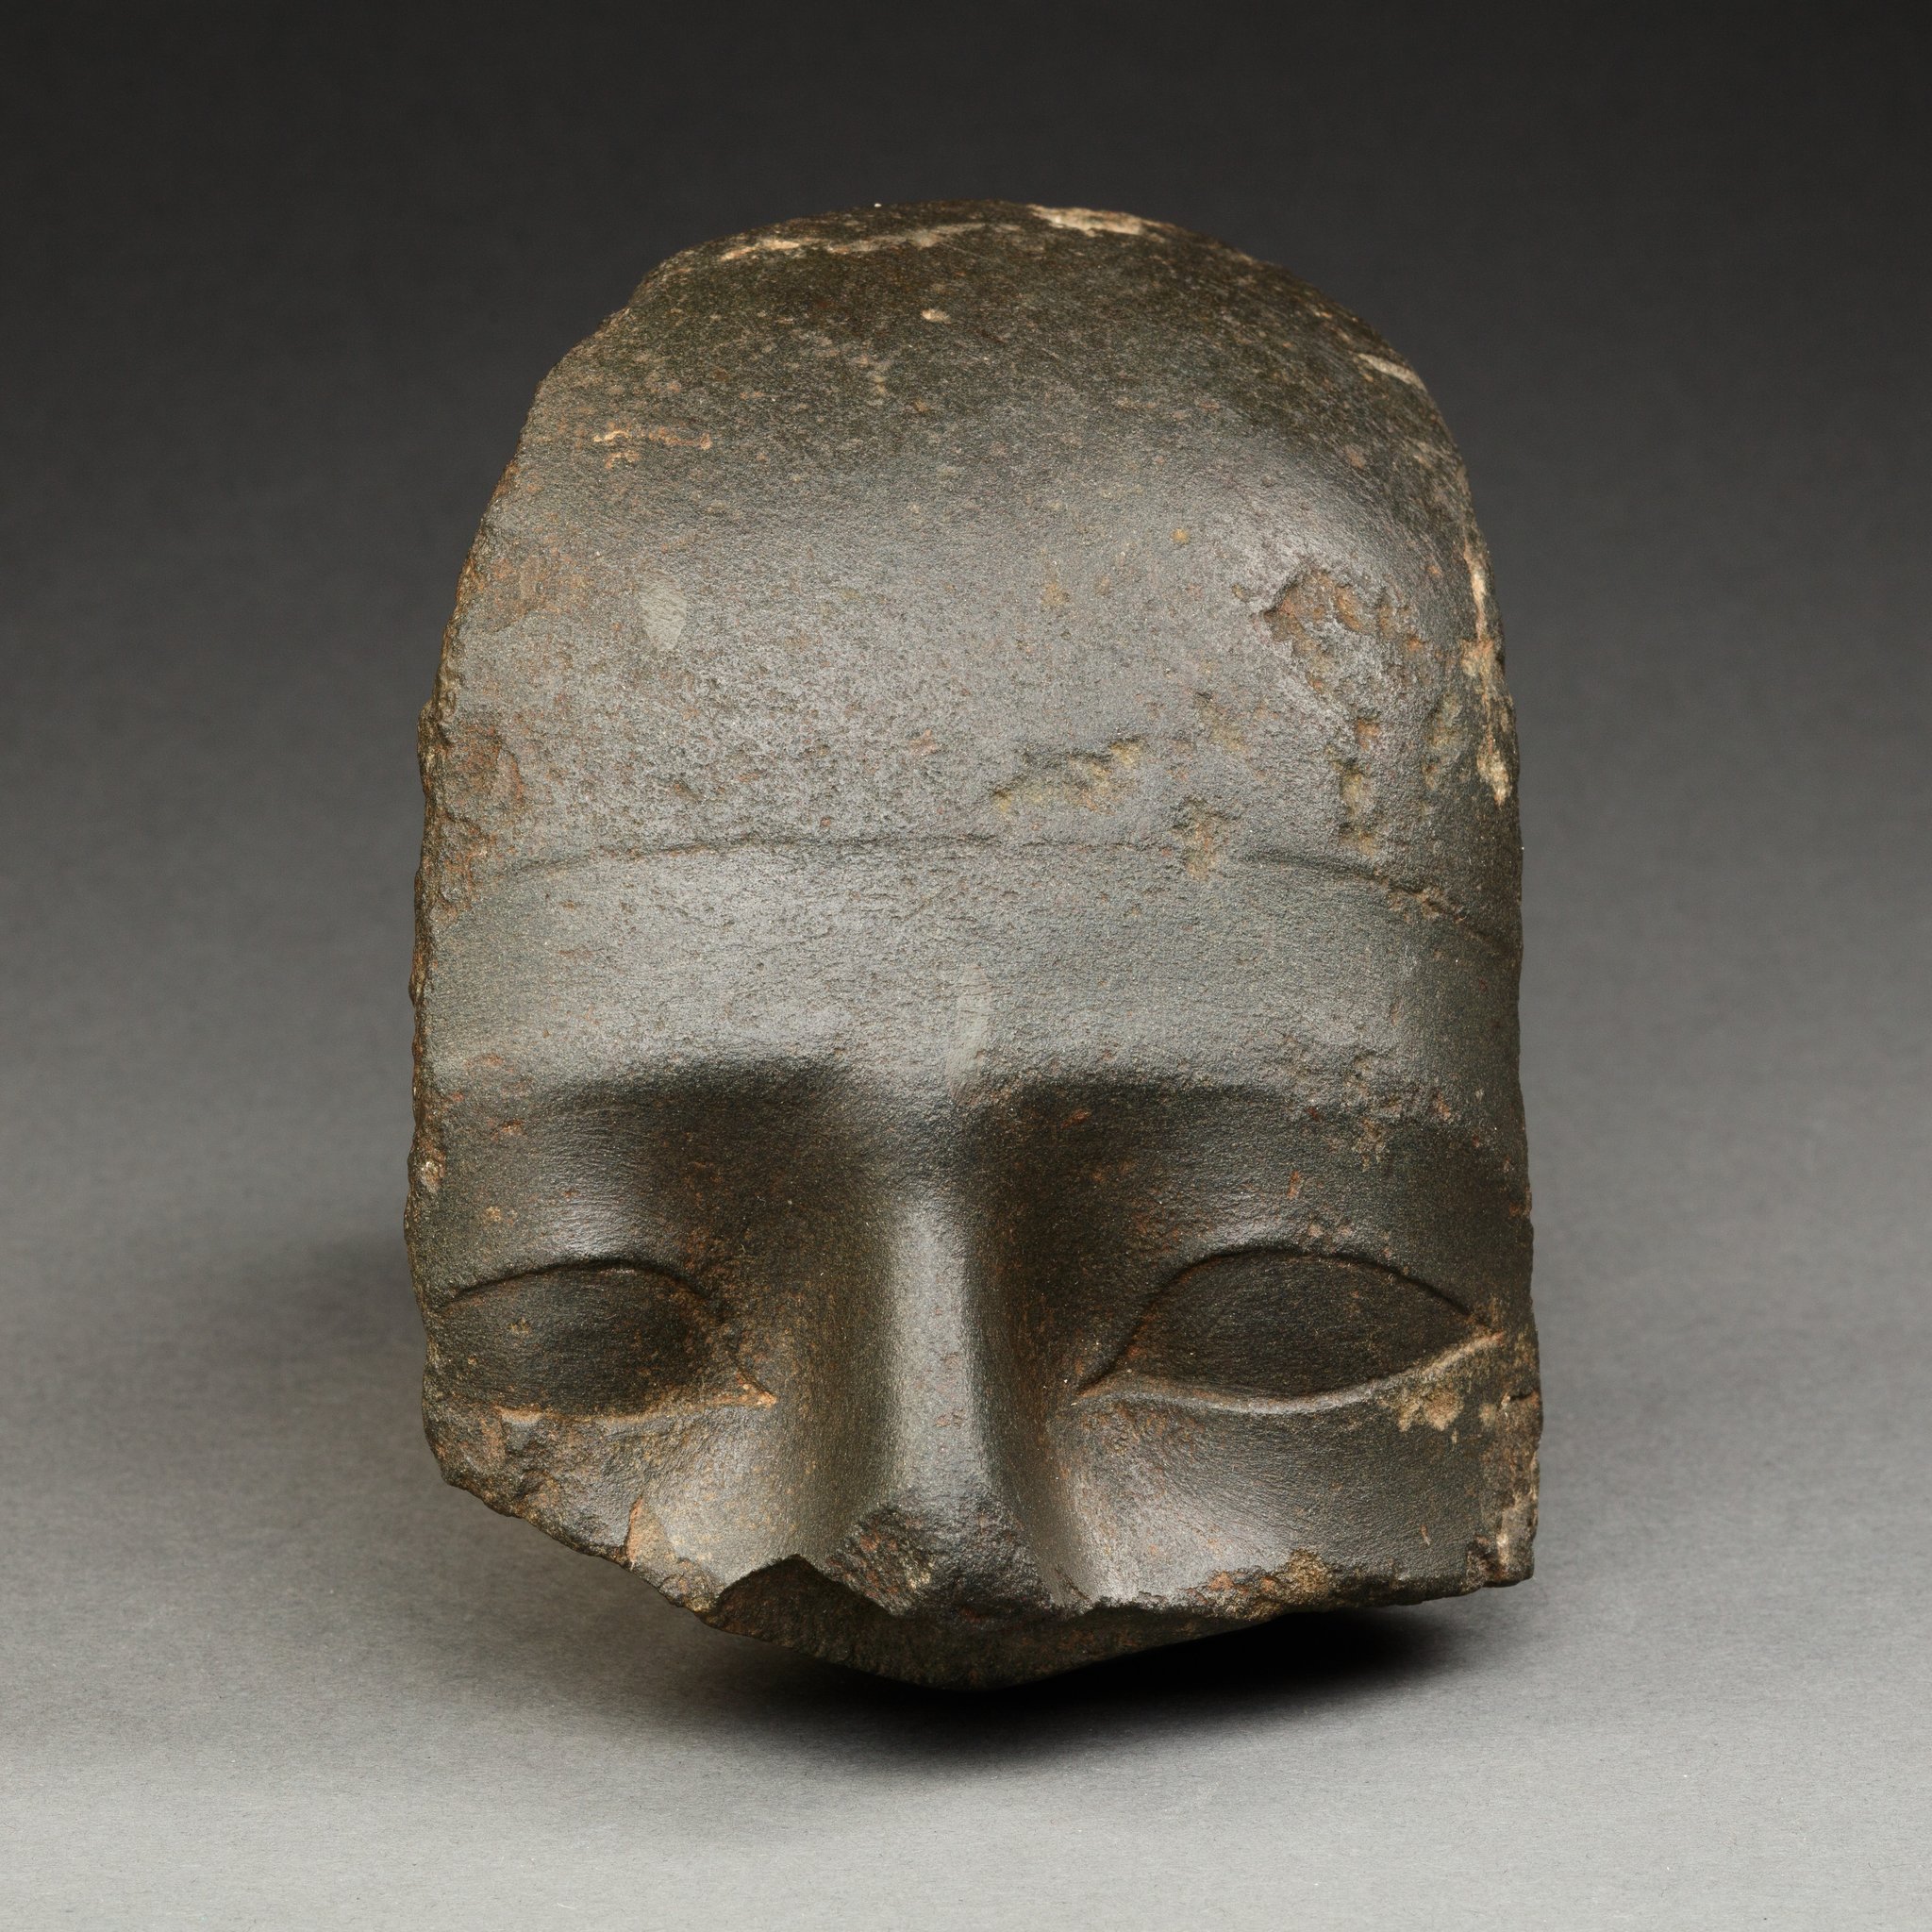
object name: upper part of the head of a man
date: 664-525 BCE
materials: stone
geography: egypt